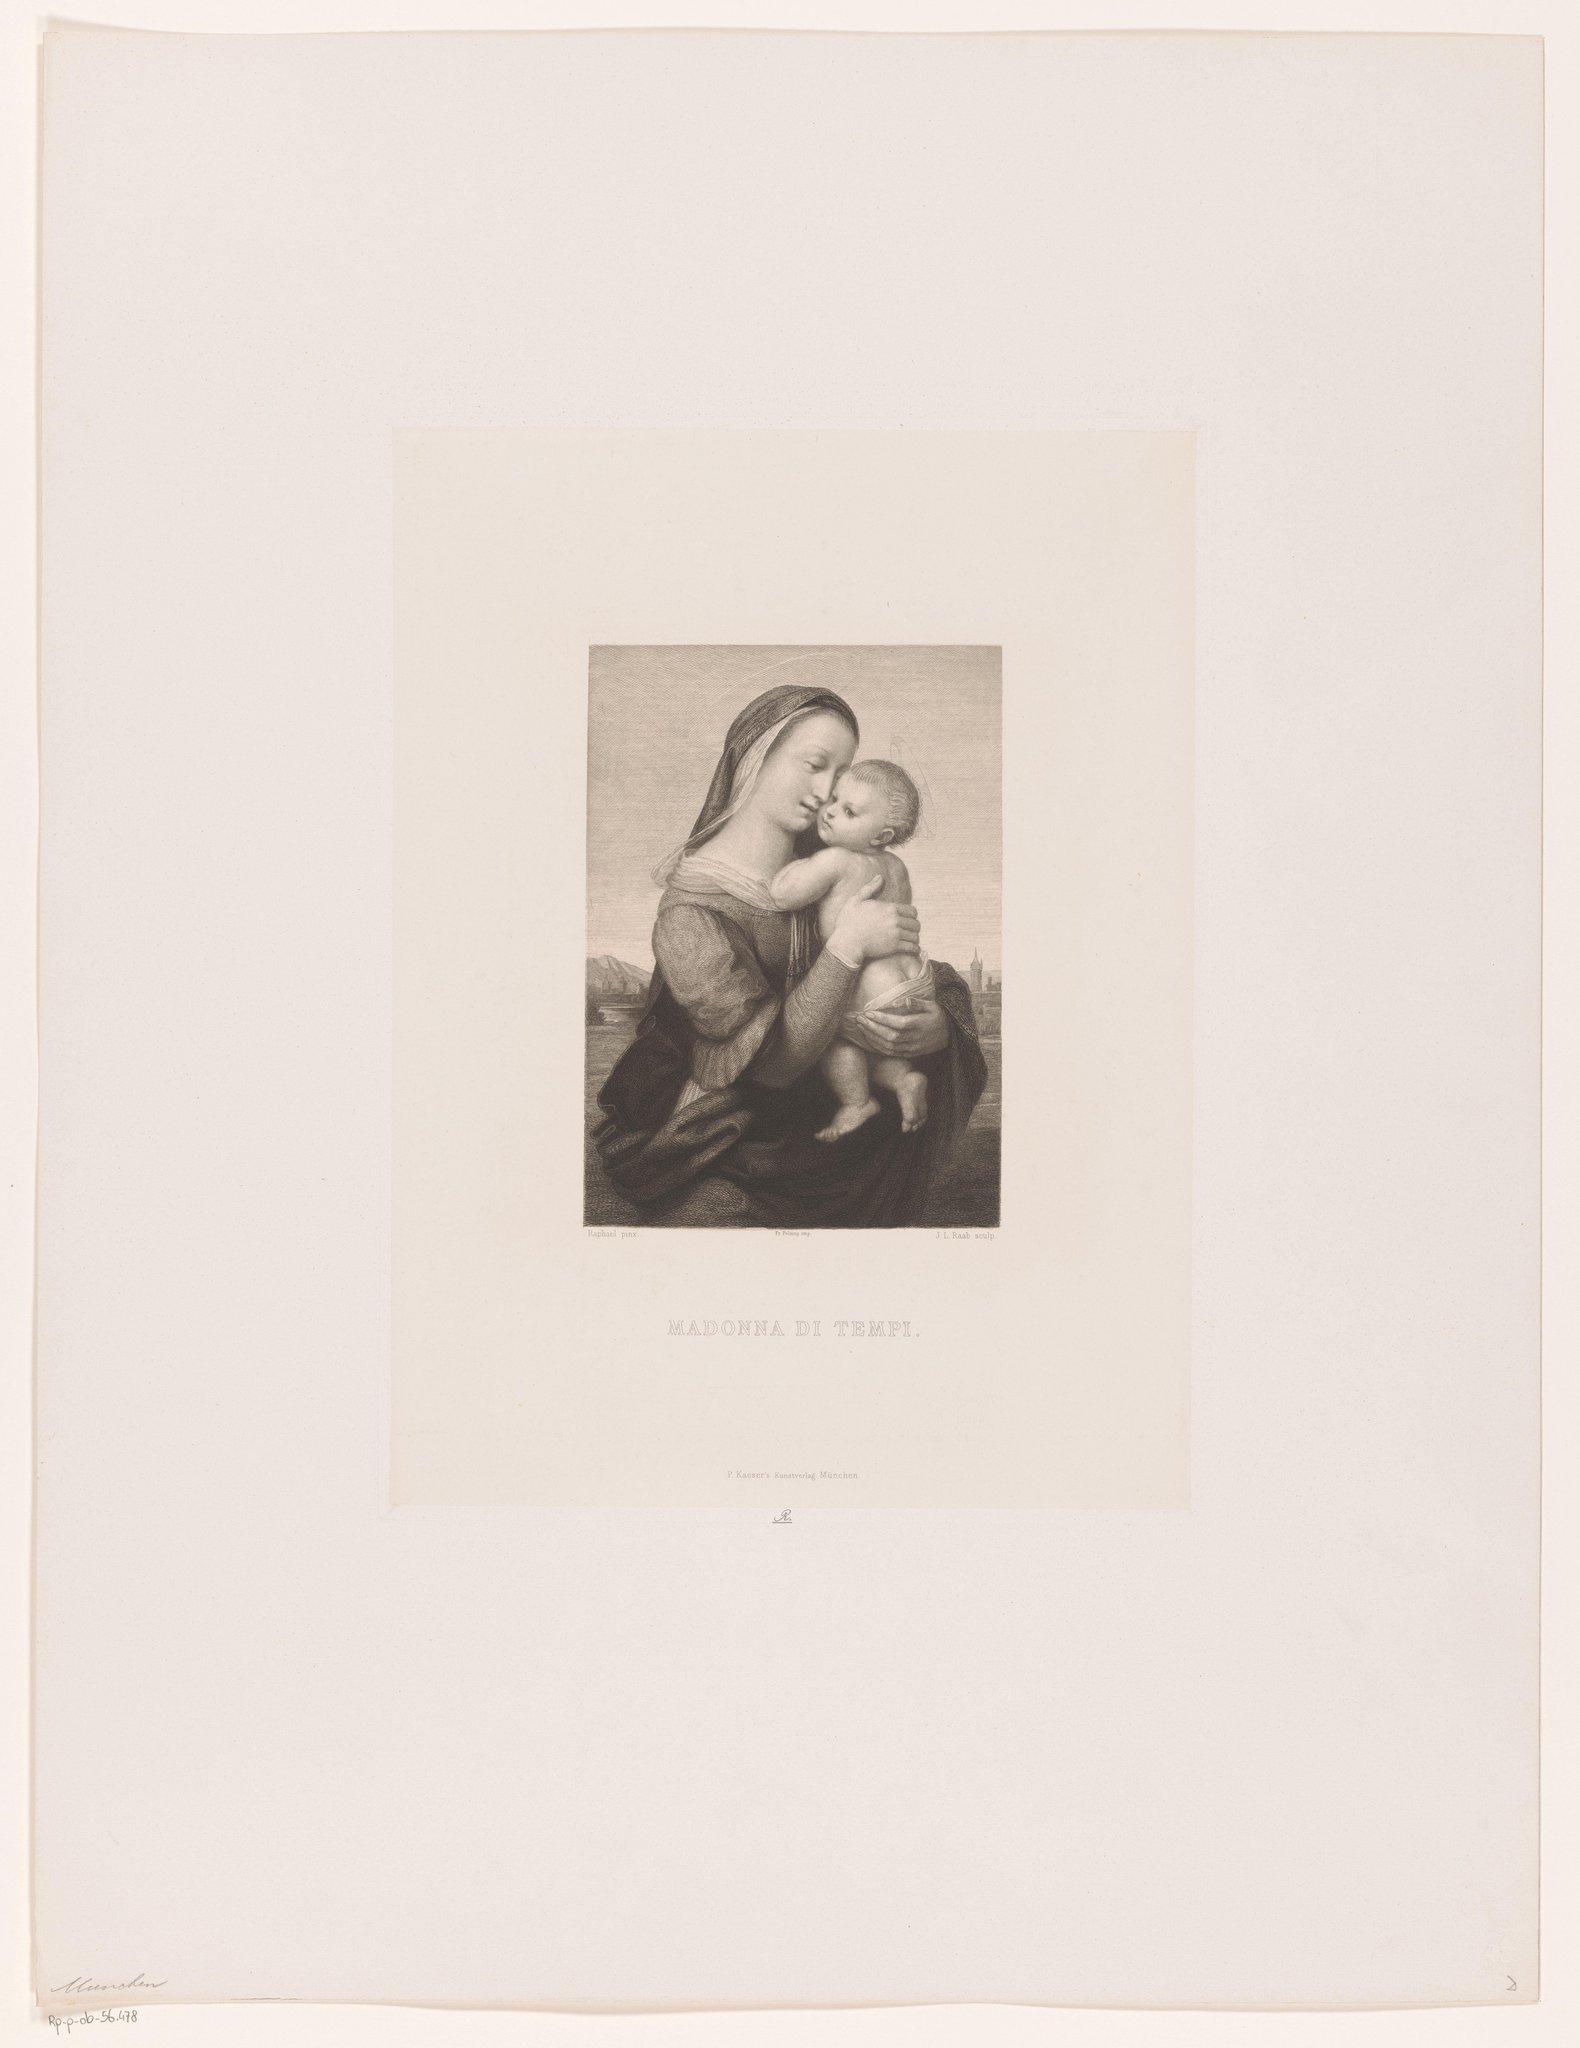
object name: print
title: Madonna di Tempi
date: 1835-1899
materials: paper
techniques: etching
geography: munich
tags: madonna: i.e. mary with the christ-child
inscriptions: collector's mark: Lugt 2228, number: ‘43’